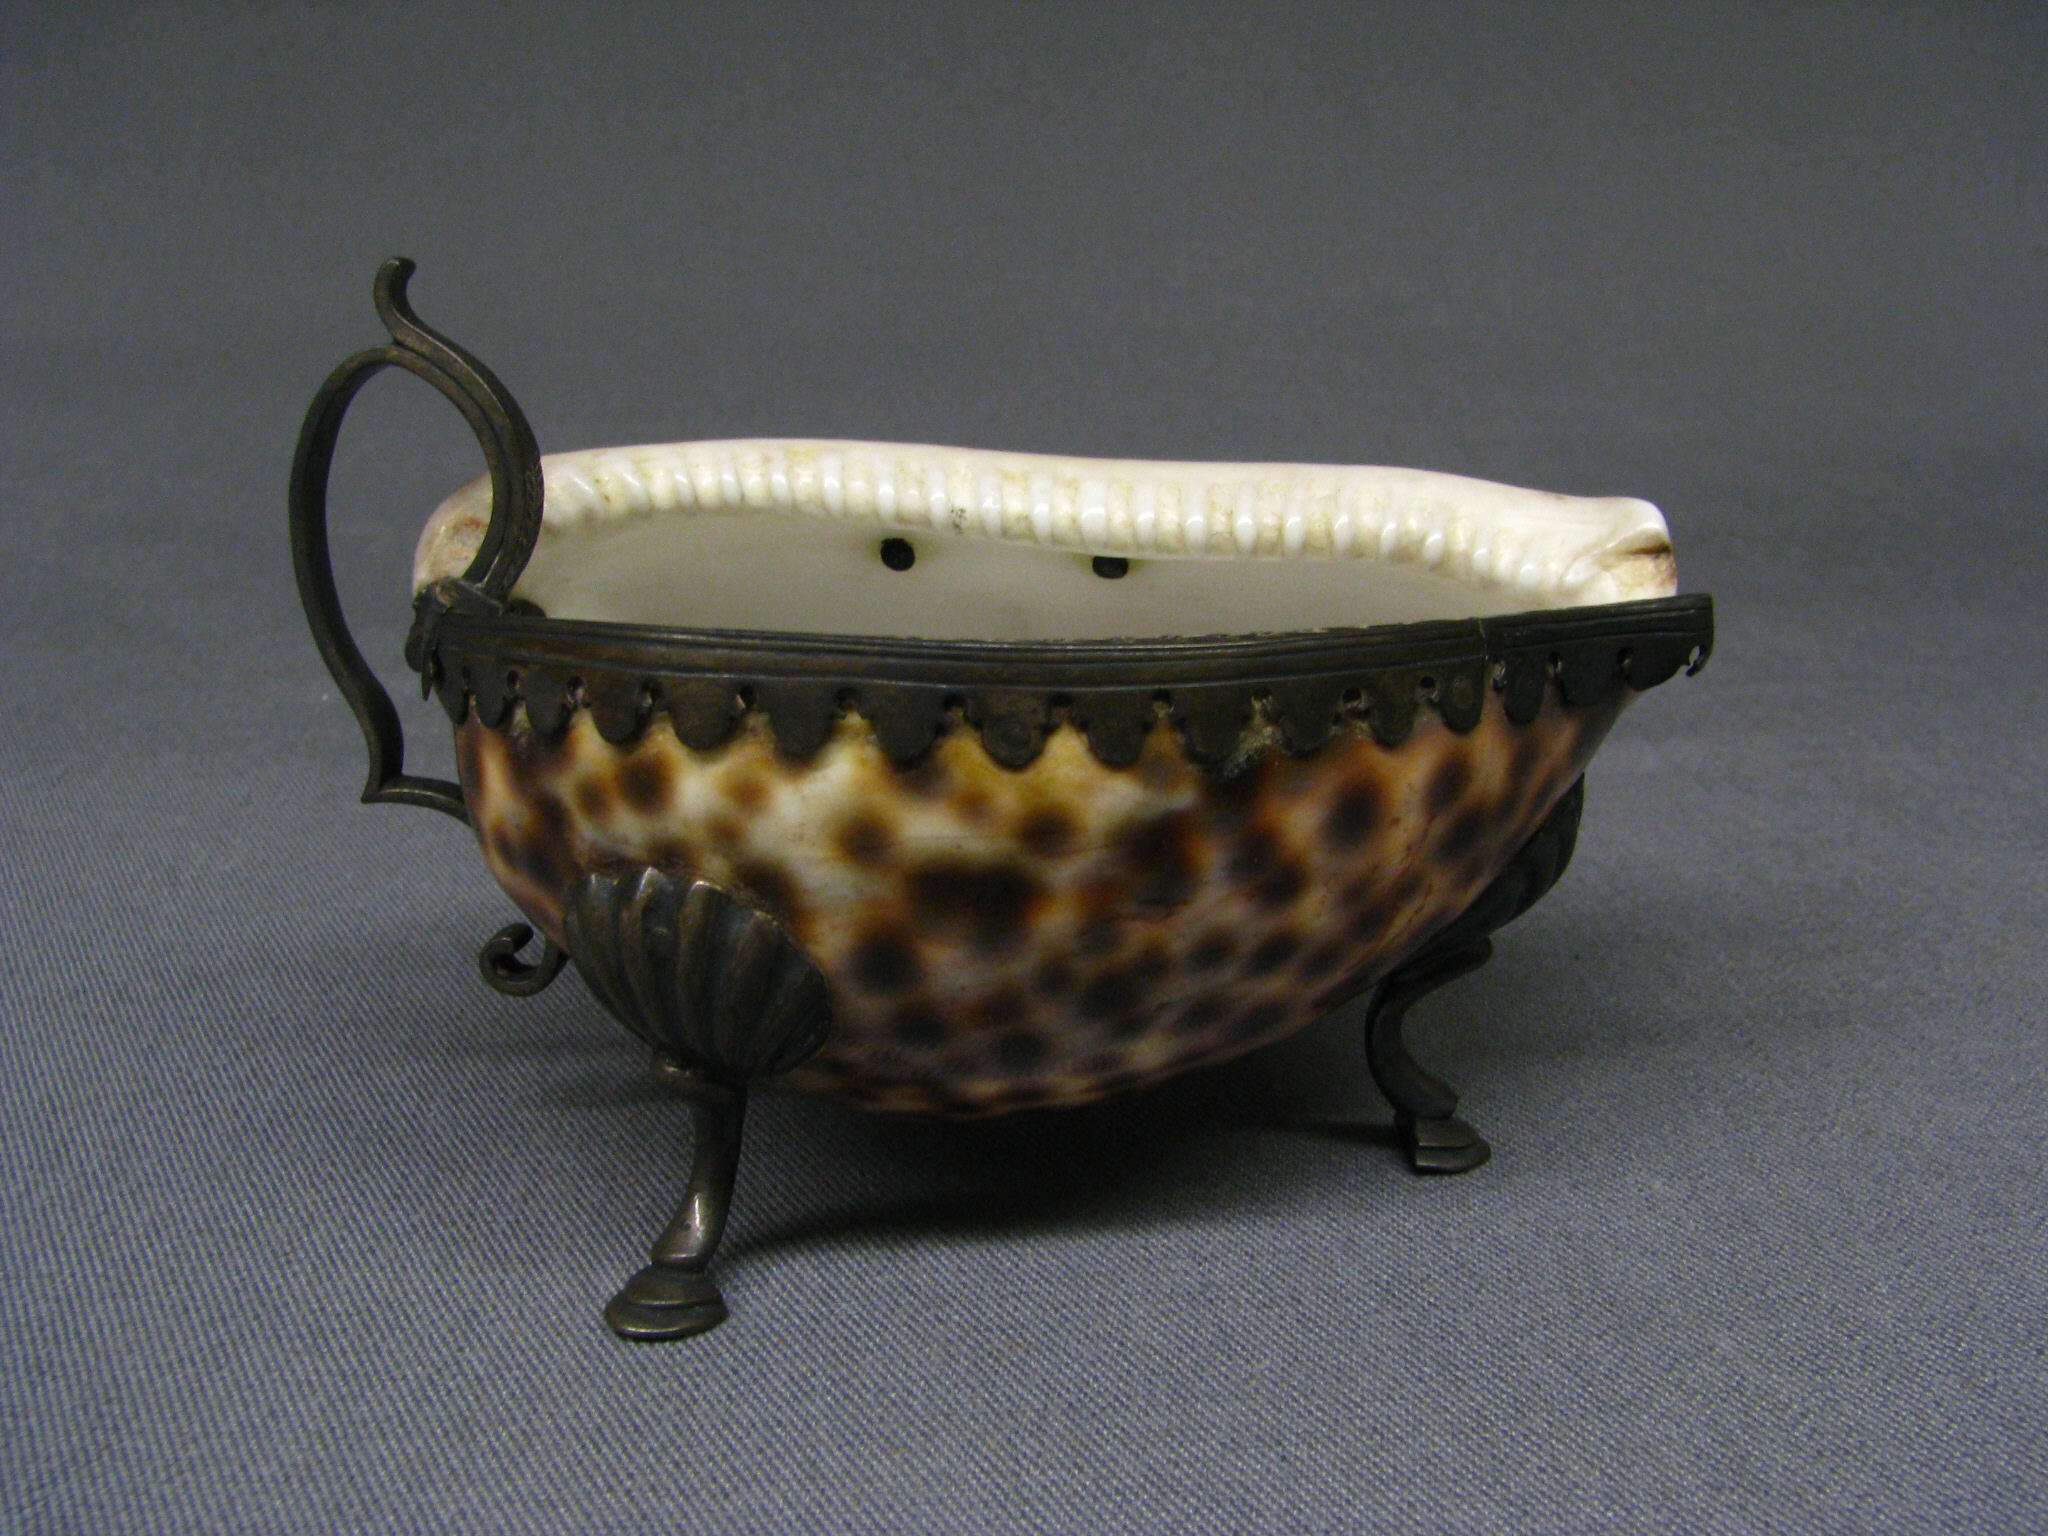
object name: cowrie shell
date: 1701-1800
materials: shell, silver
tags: shells